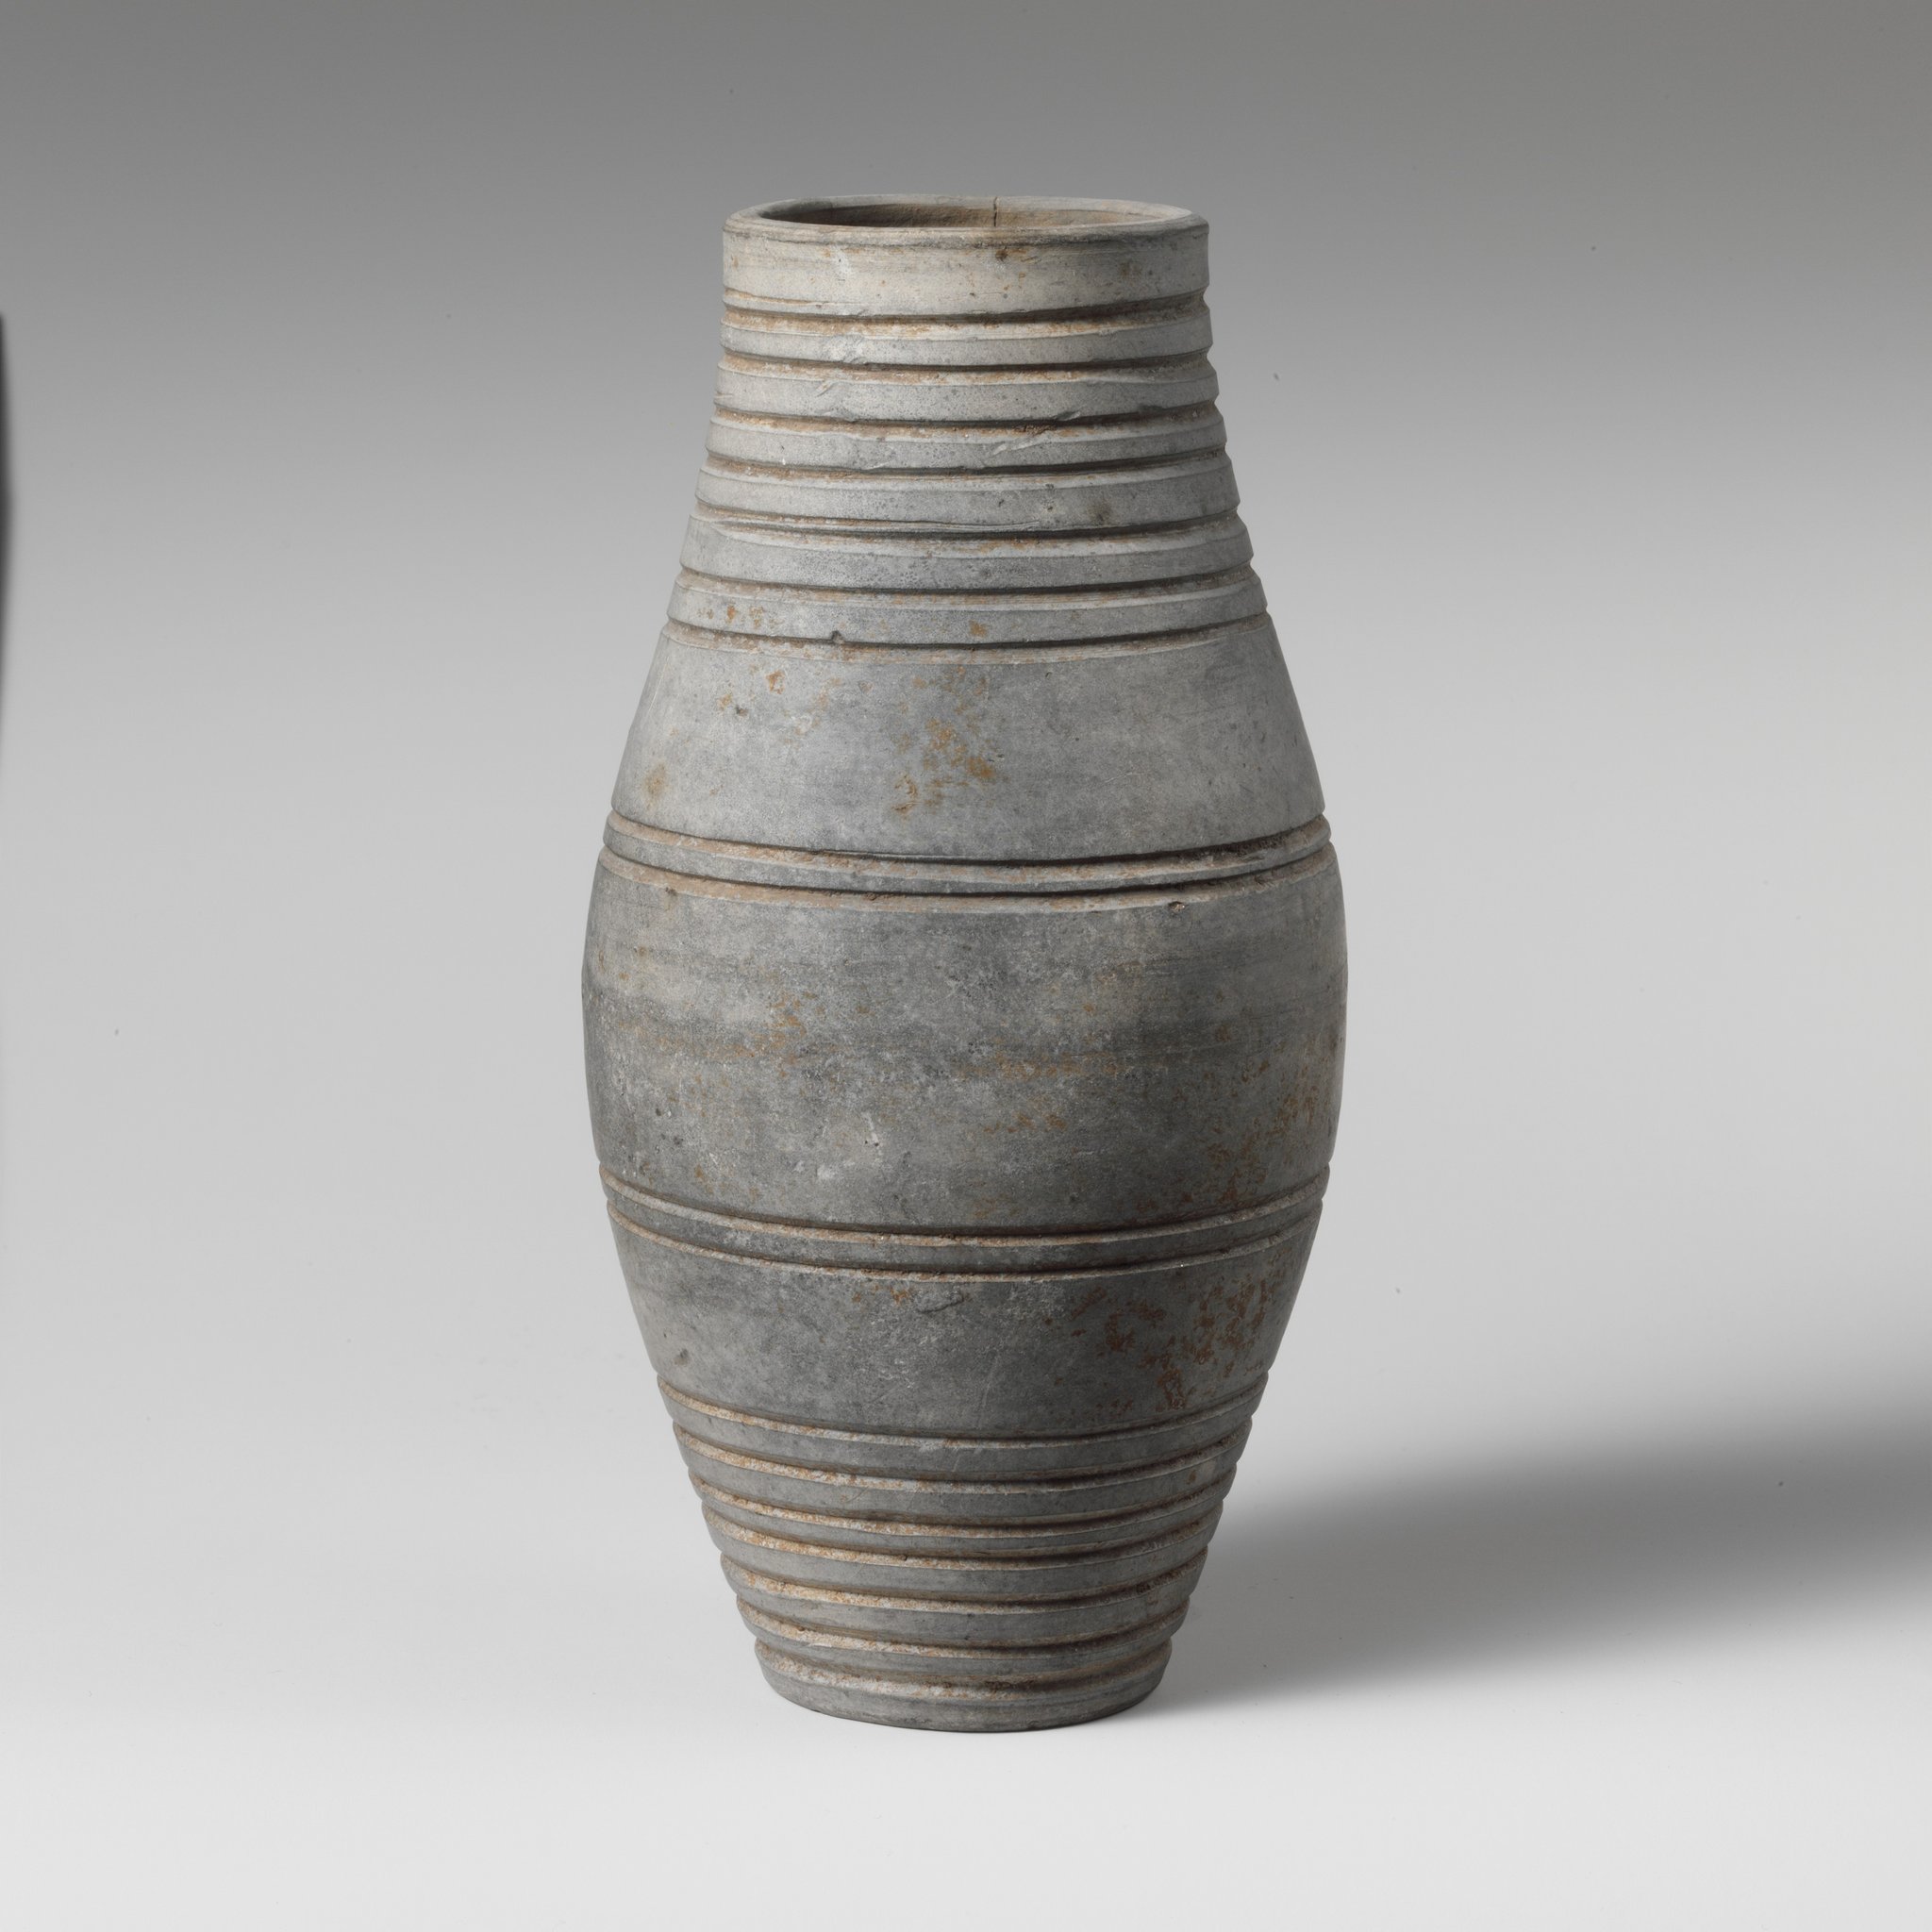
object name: jar, barrel shaped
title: Terracotta barrel-shaped jar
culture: roman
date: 101-300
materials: terracotta